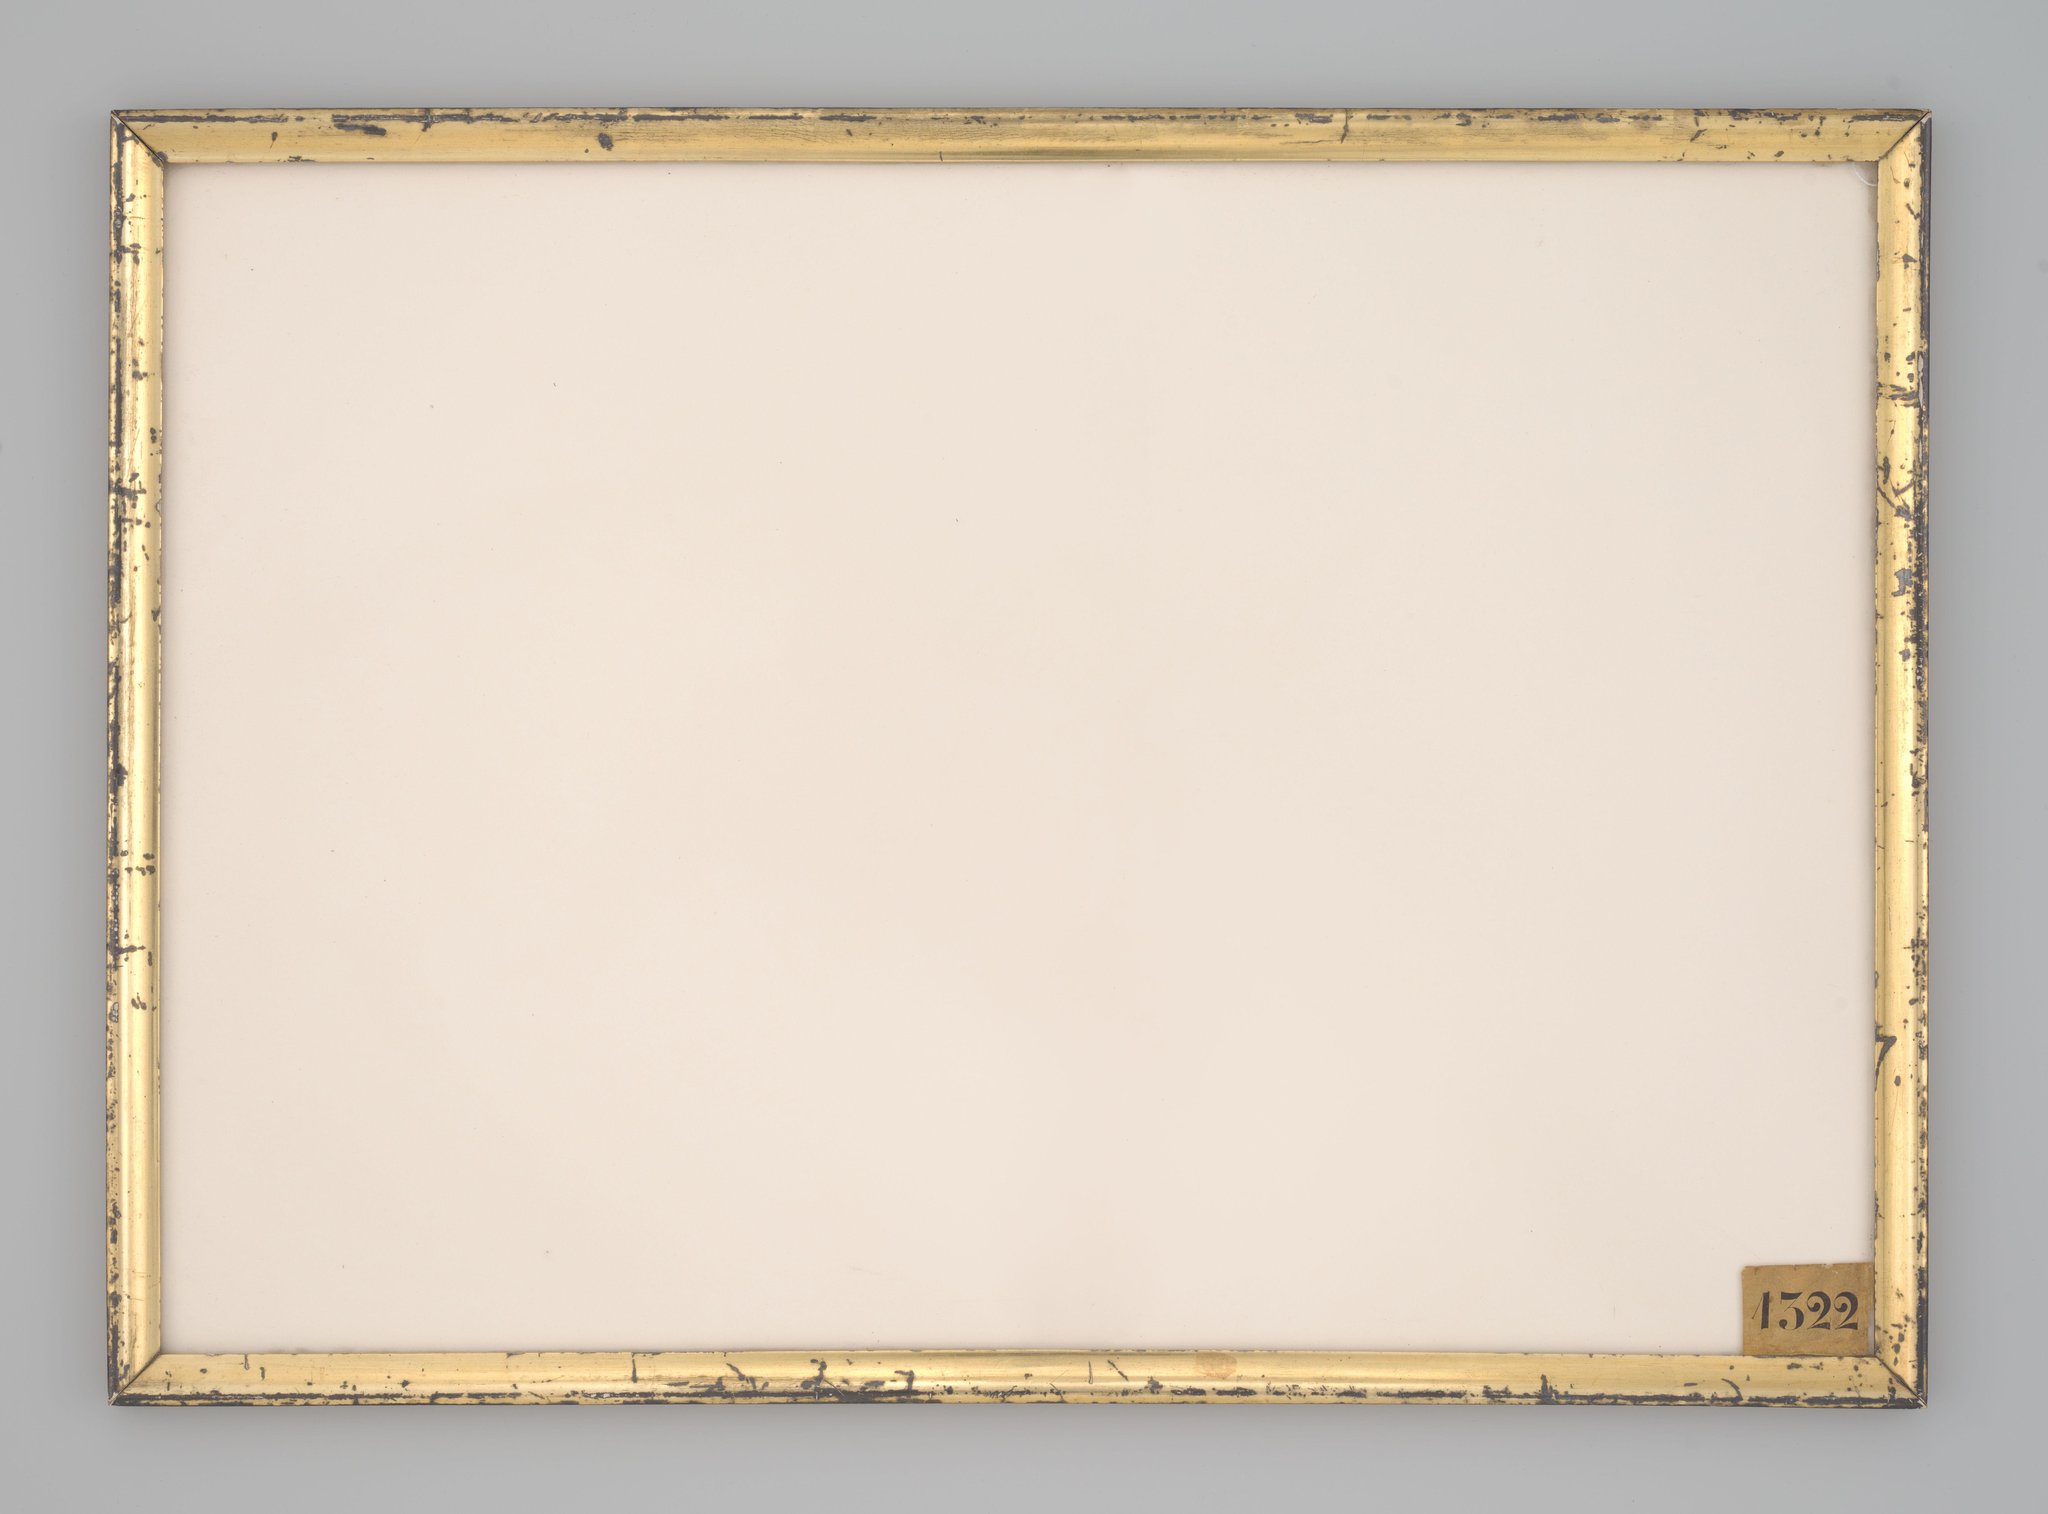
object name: frame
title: Picture Frame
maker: Anonymous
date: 1800-1883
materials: cardboard, glass, gypsum, wood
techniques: gilding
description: Lijst behorende bij foto van het Amerikaans pantserschip Chickasaw.